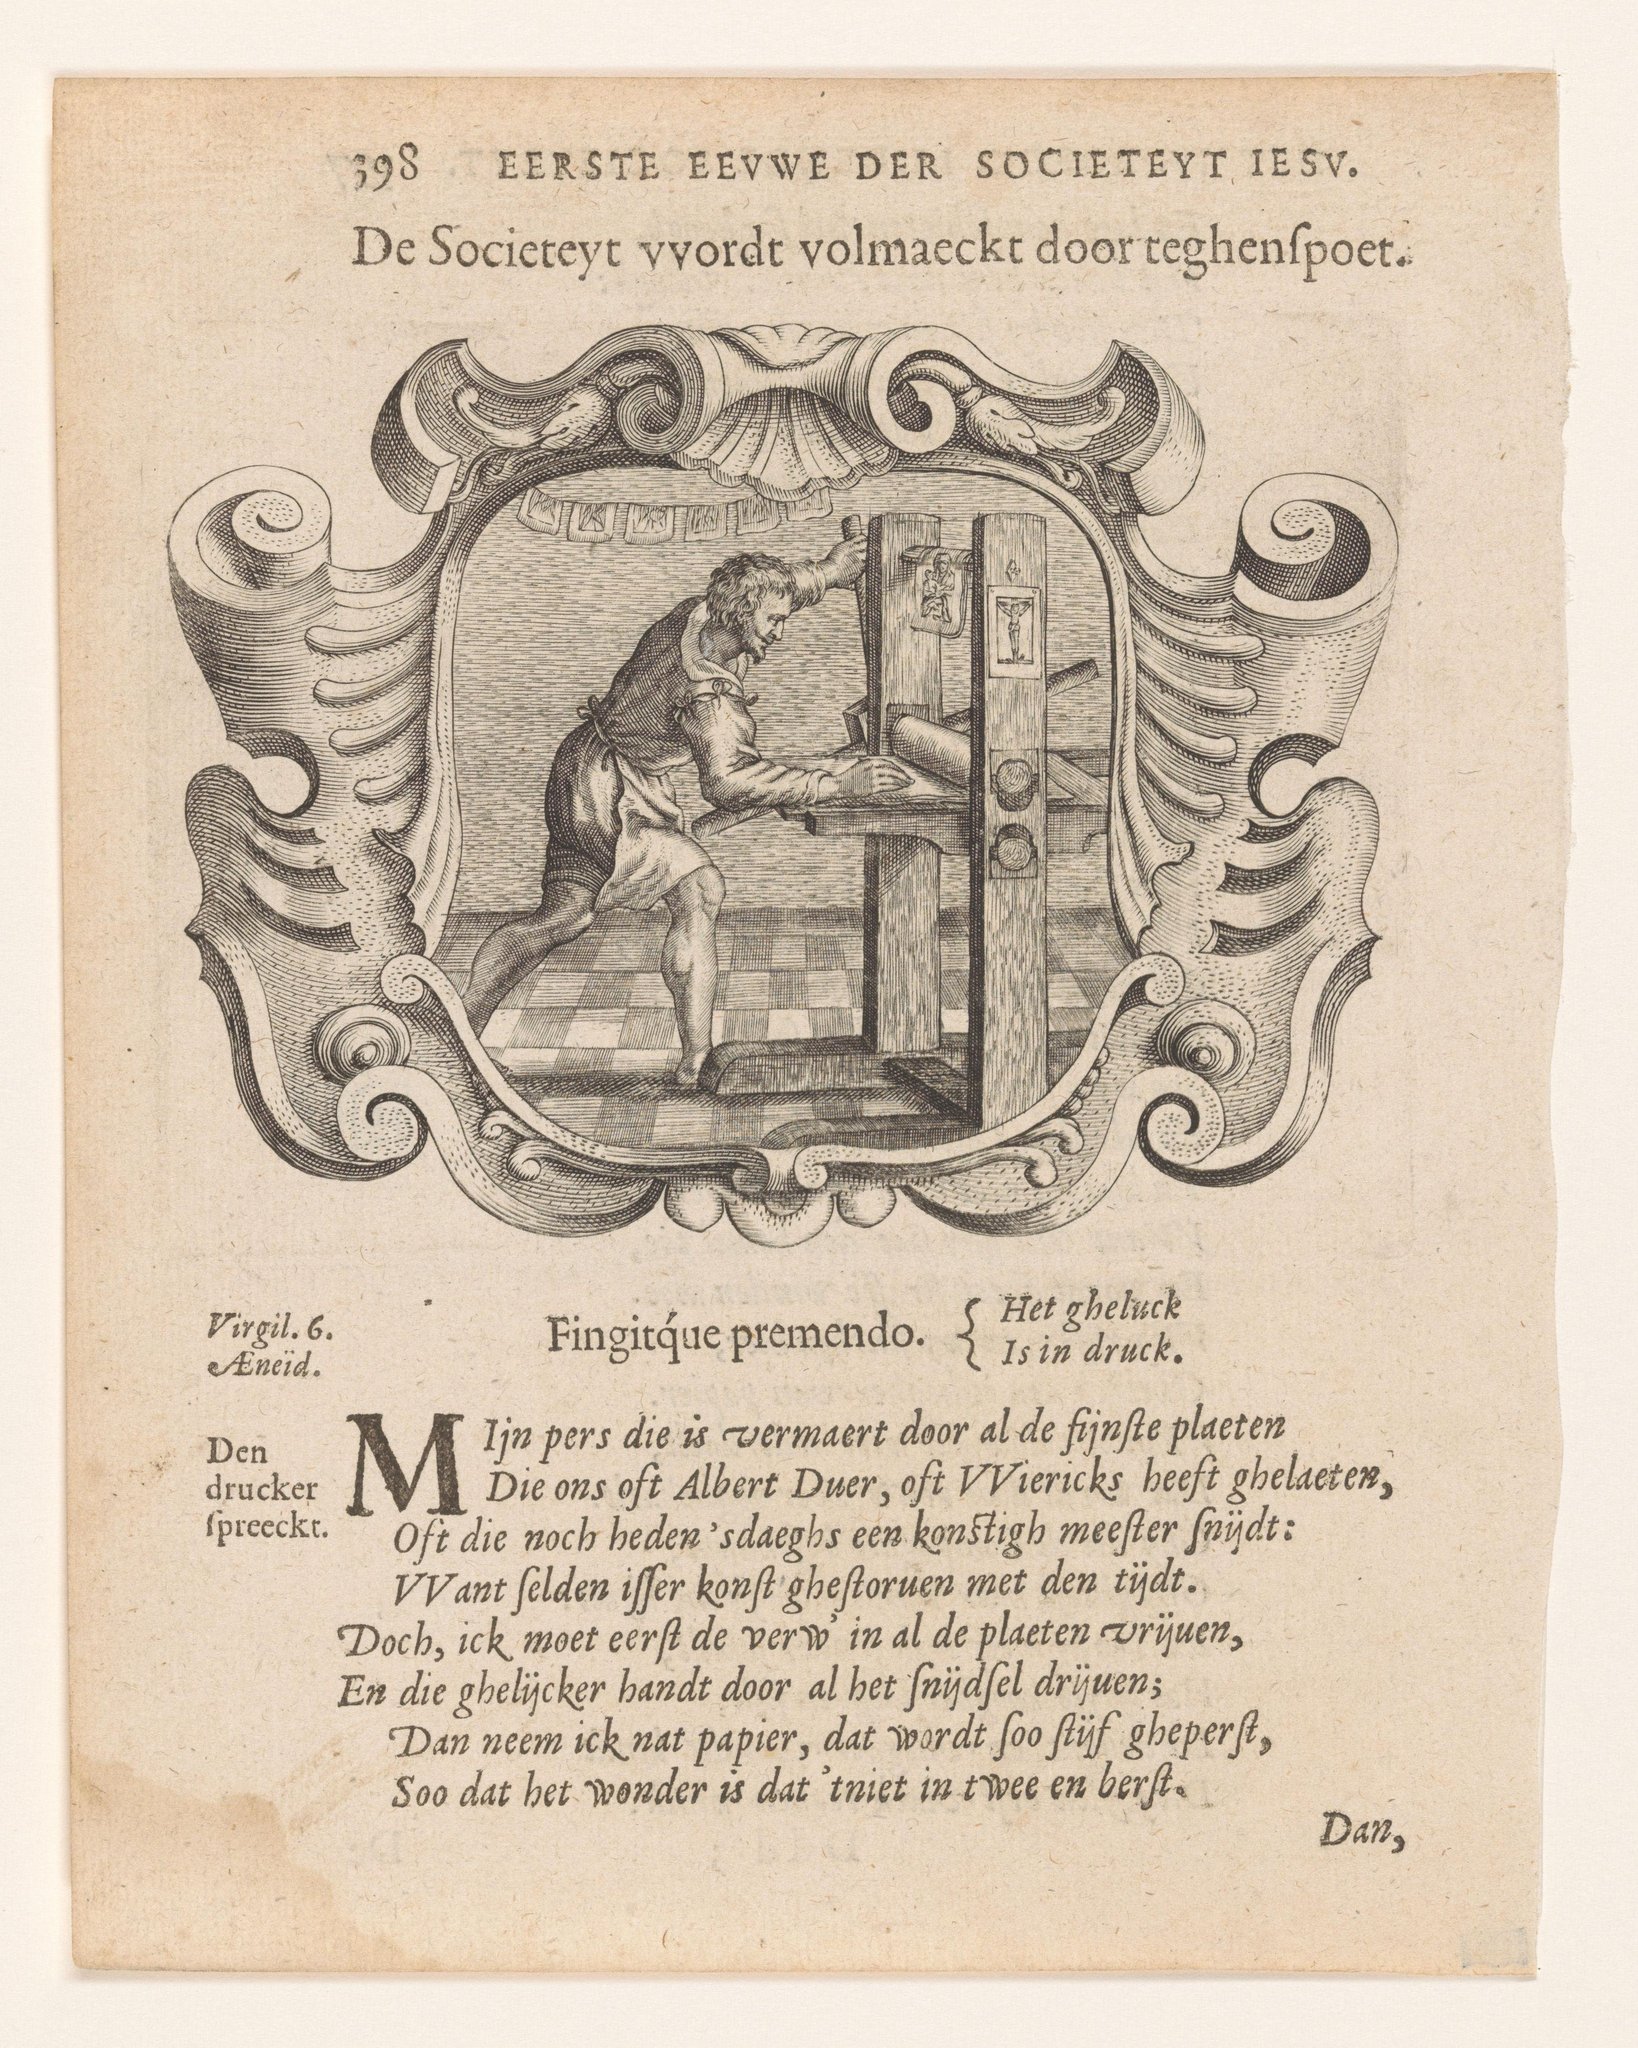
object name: book illustration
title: Fingitque premendo / Het gheluck is in druck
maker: cornelis galle (i)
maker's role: print maker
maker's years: 1576-1650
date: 1640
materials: paper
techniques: engraving, letterpress printing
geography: antwerp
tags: scrollwork, strapwork ~ ornament, printing press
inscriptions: collector's mark: Lugt 4779, collector's mark: Lugt 2228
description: Een man achter een plaatpers, bezig met het afdrukken van prenten. Aan de pers hangen twee religieuze prenten: Christus aan het kruis en Maria met kind. Aan een lijn hangen prenten te drogen. Linksboven genummerd: 398.